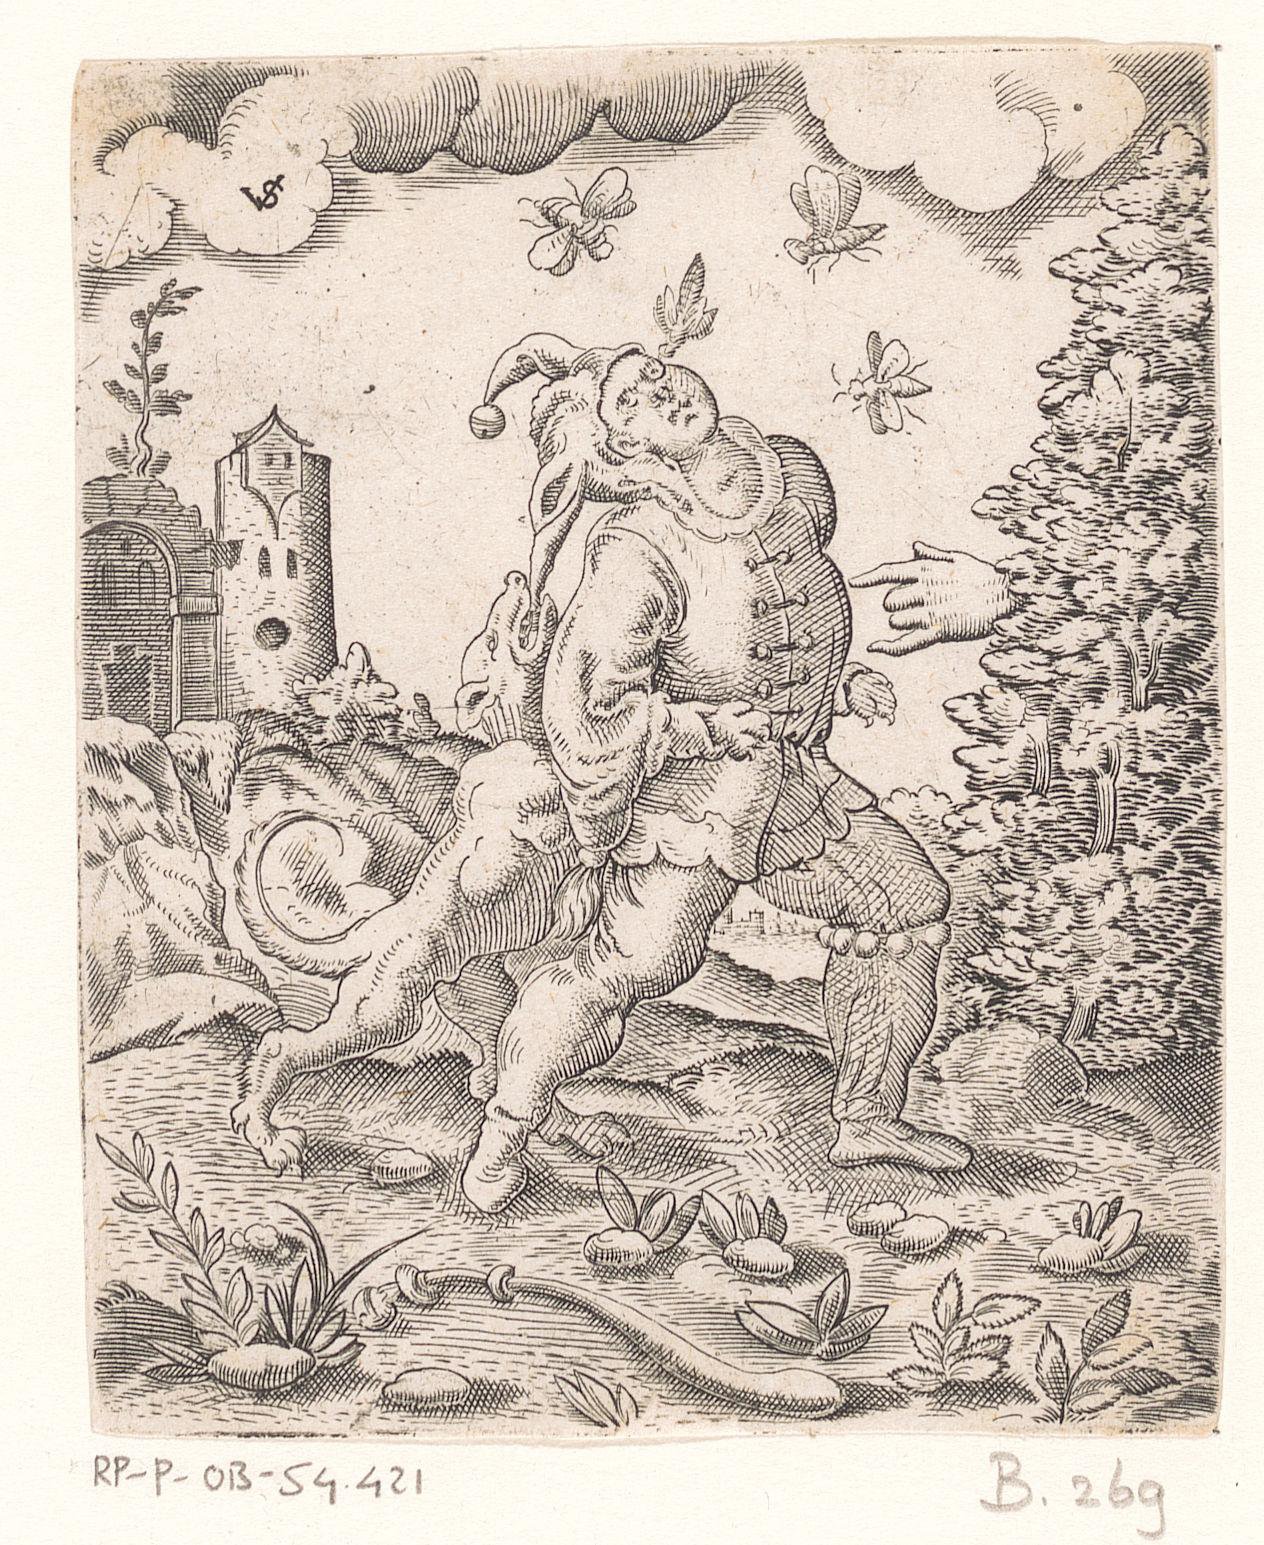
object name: print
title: Nar aangevallen door wespen en een hond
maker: virgilius solis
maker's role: draughtsman, print maker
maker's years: 1514-1562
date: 1524-1562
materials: paper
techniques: engraving, etching, intaglio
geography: nuremberg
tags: court jester, court fool, insects: wasp, dog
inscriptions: number: ‘91’, collector's mark: Lugt 2228